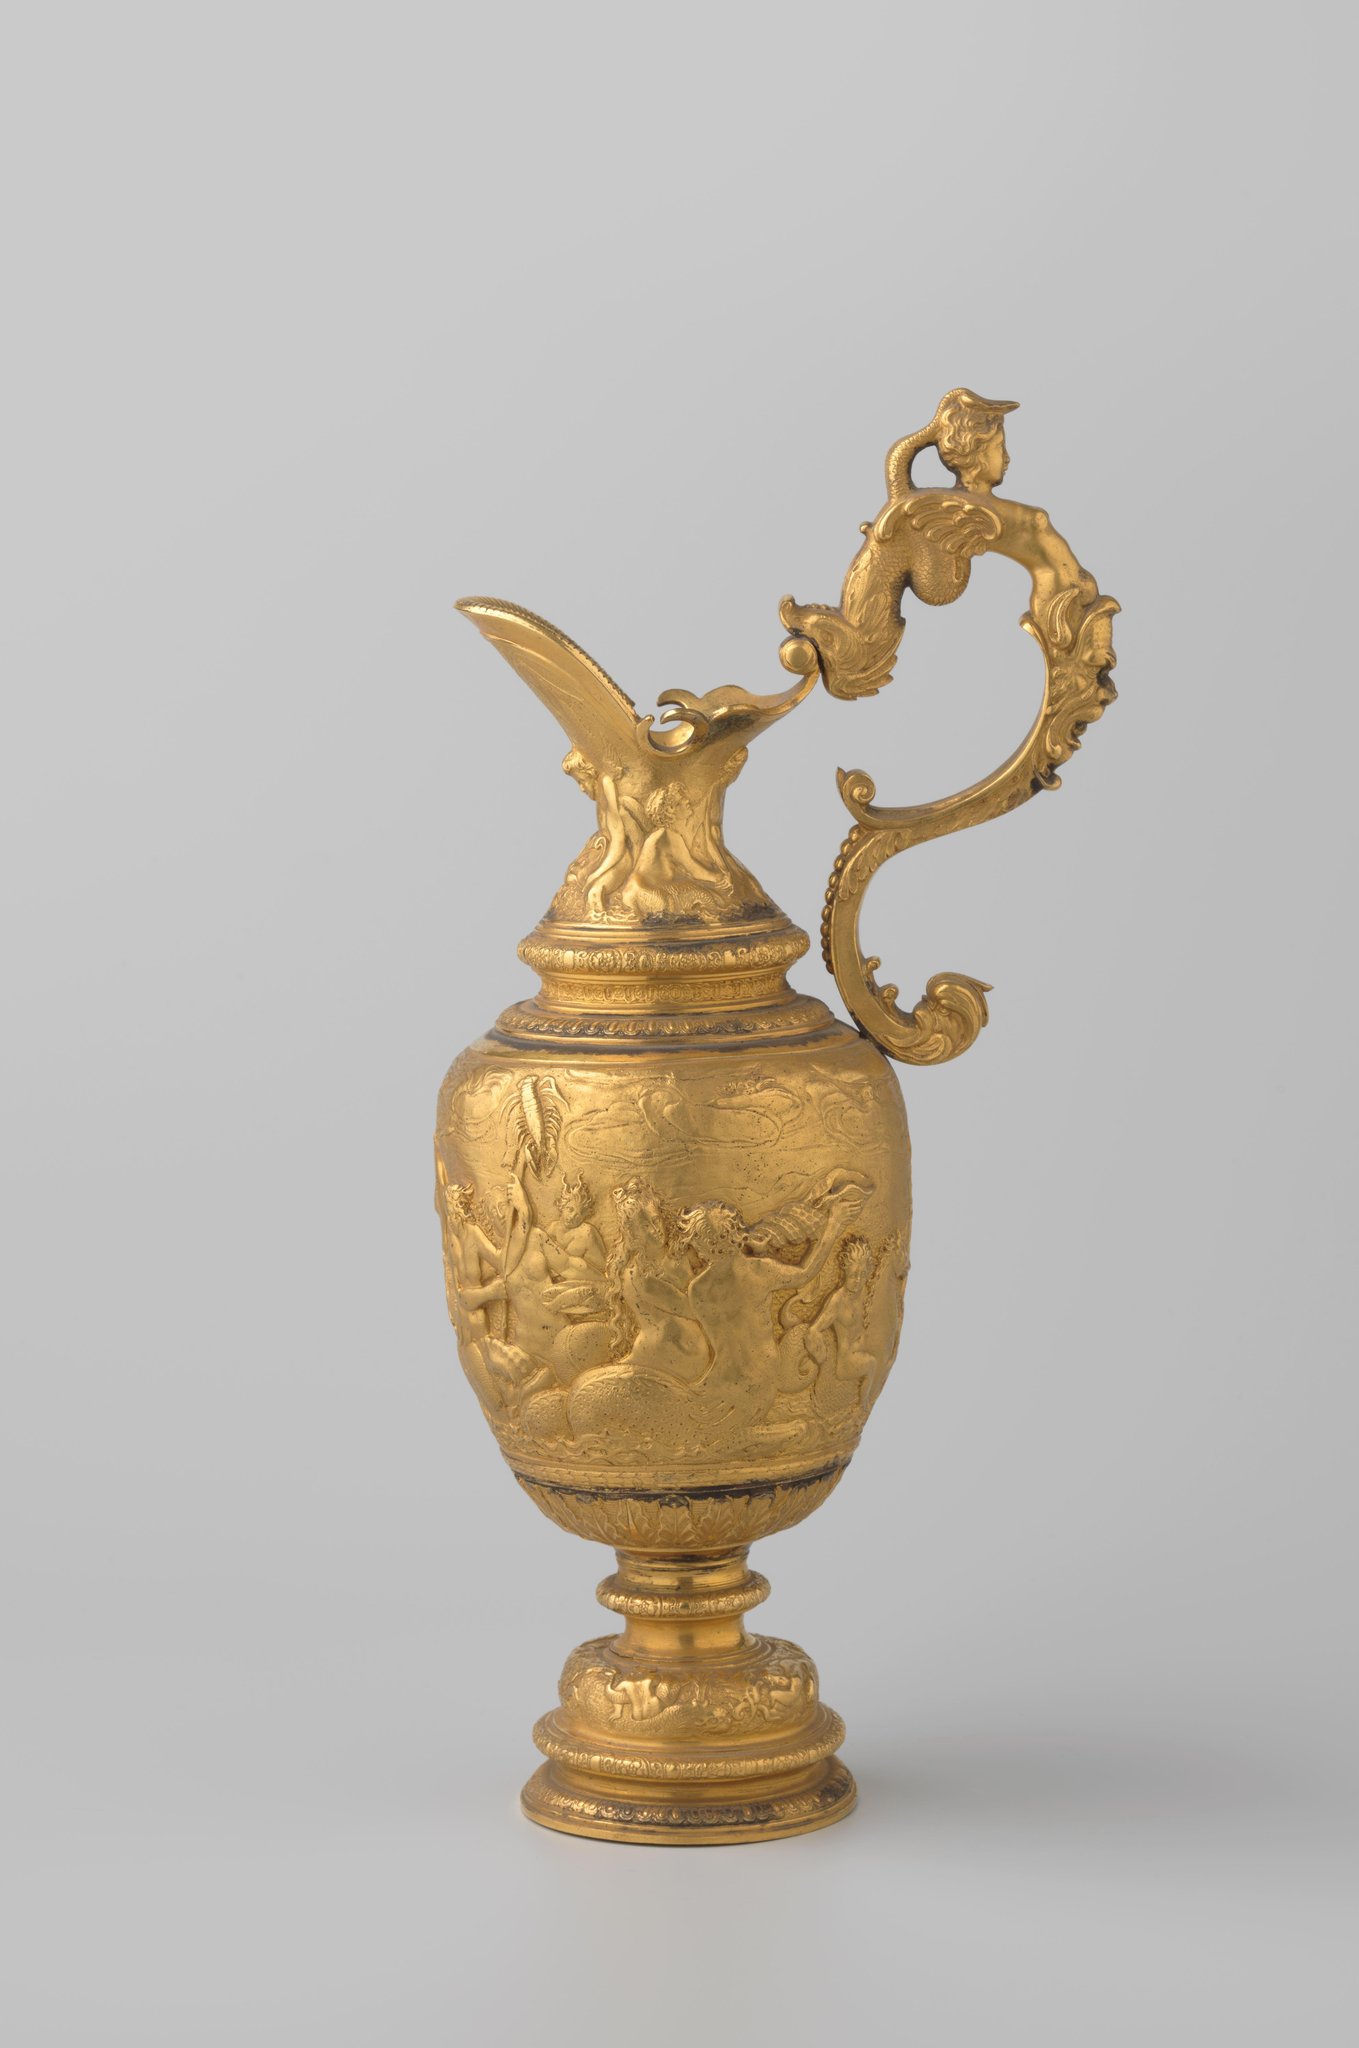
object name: ewer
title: Galvanoplastische reproductie van een kan met optochten van zeegoden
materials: copper, silver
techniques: gilding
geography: london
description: Galvanoplastische reproductie van een kan, gedreven, het handvat bestaande uit een zeenimf en een dolfijn; rond de hals, de buik en de voet voorstellingen van triomfen en optochten van zeegoden. Verguld.